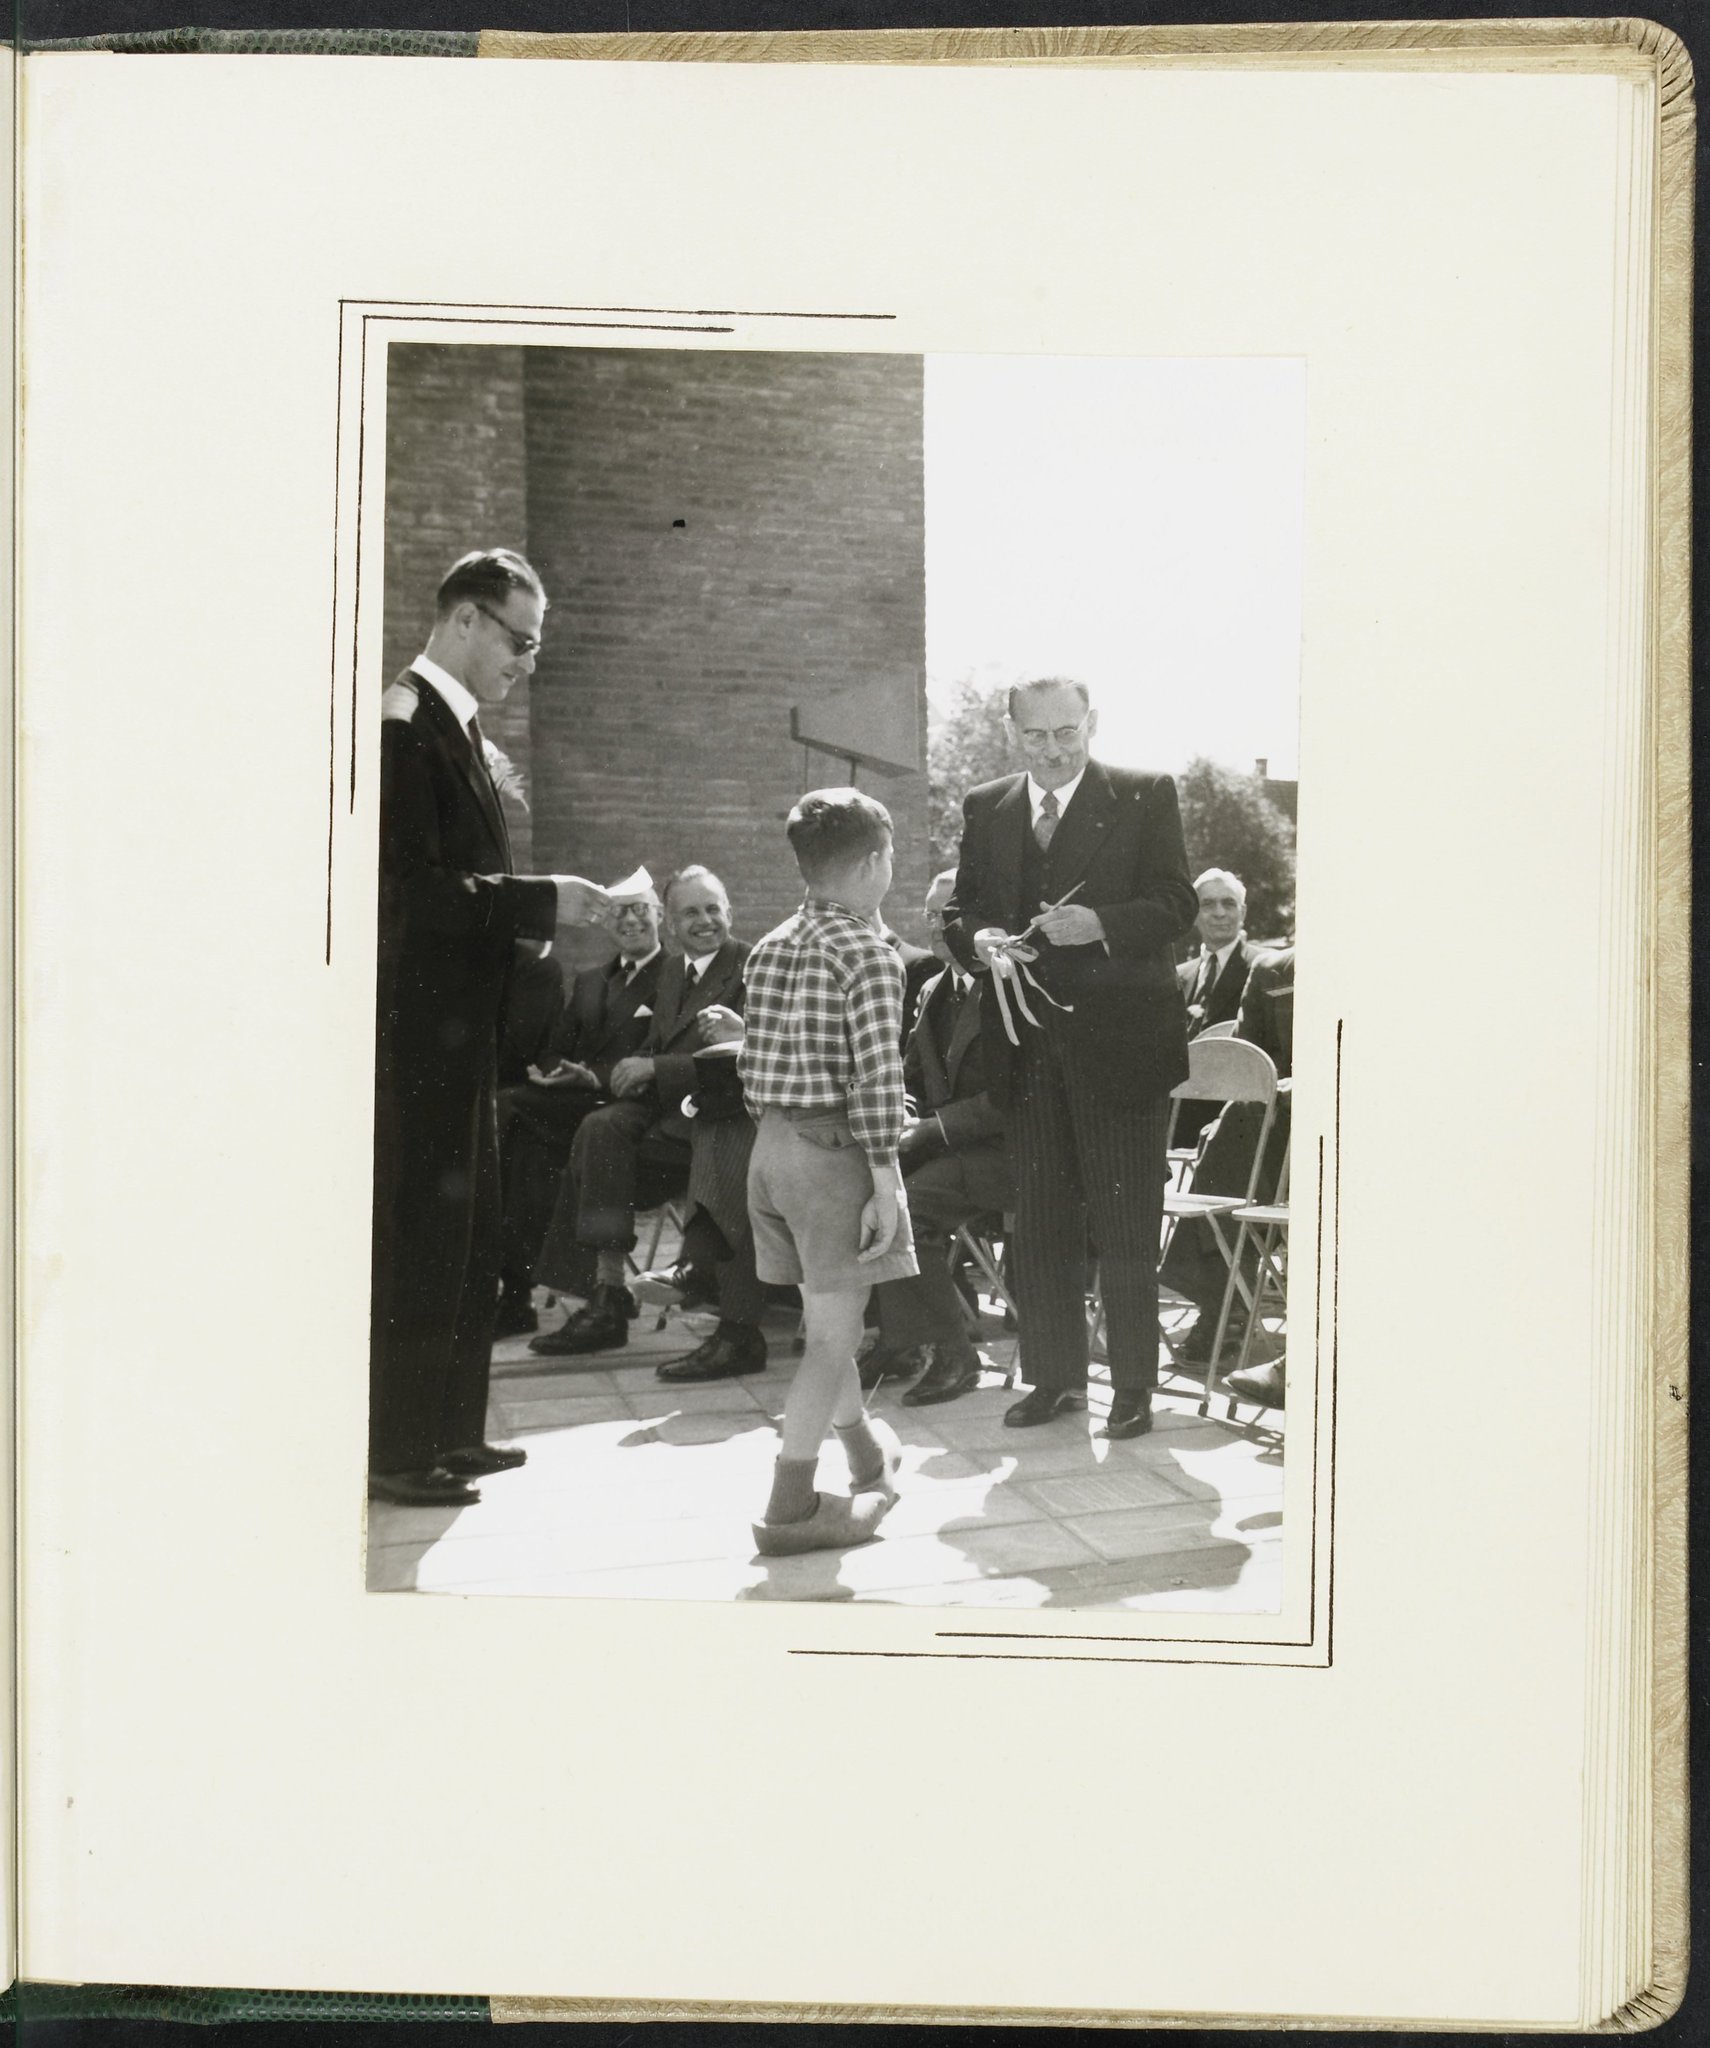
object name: album leaf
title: Drees ontvangt de schaar om het lint door te knippen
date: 1953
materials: paper, photographic support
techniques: gelatin silver print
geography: lochem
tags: amsterdam, the hague, willem drees, prime minister, activities in the air ~ public festivities, e.g. fly-past, tools, aids, implements ~ crafts and industries: scissors, old-people's home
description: Minister-president Willem Drees krijgt de schaar overhandigd van een jongen op klompen waarmee hij het lint gaat doorknippen. Onderdeel van het fotoalbum over de opening van bejaardenhuis De Berkelhof in Lochem door Dr. W. Drees op 8 augustus 1953.